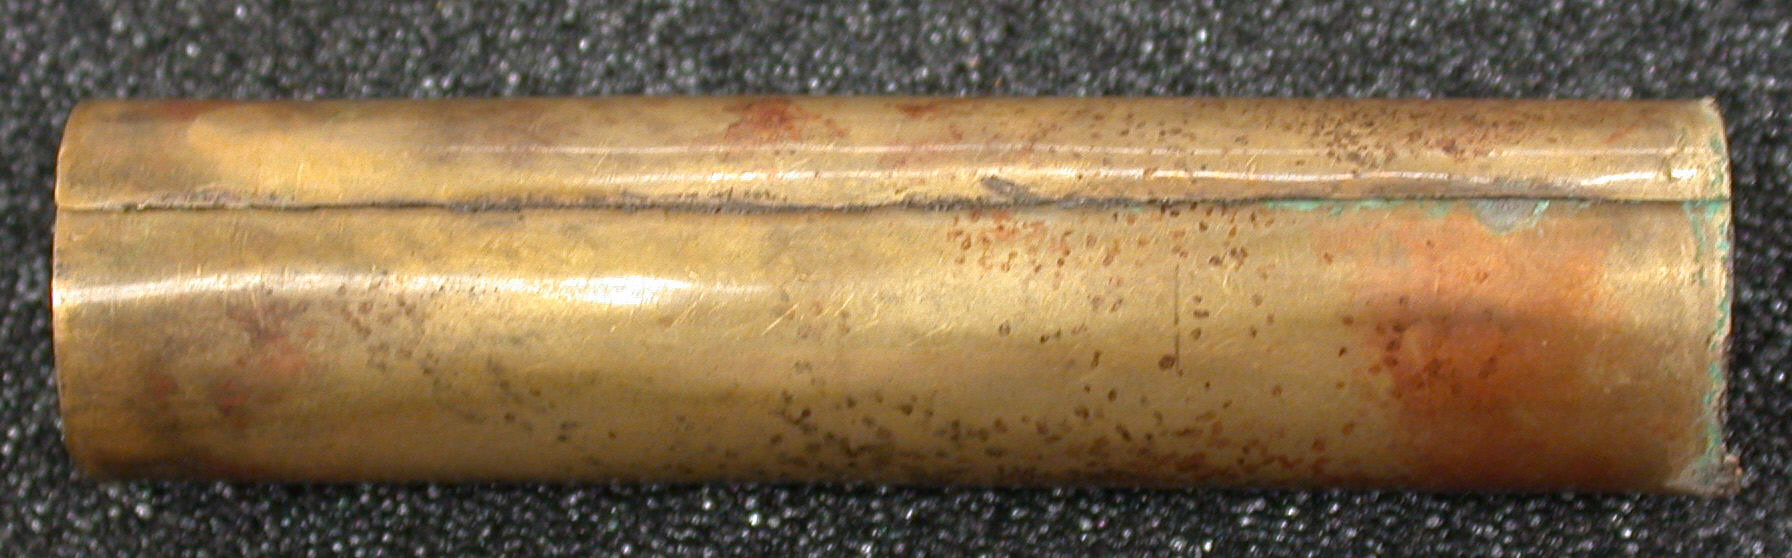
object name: earflare fragment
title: Earflare Shaft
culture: moche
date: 501-700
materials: gilt copper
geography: peru